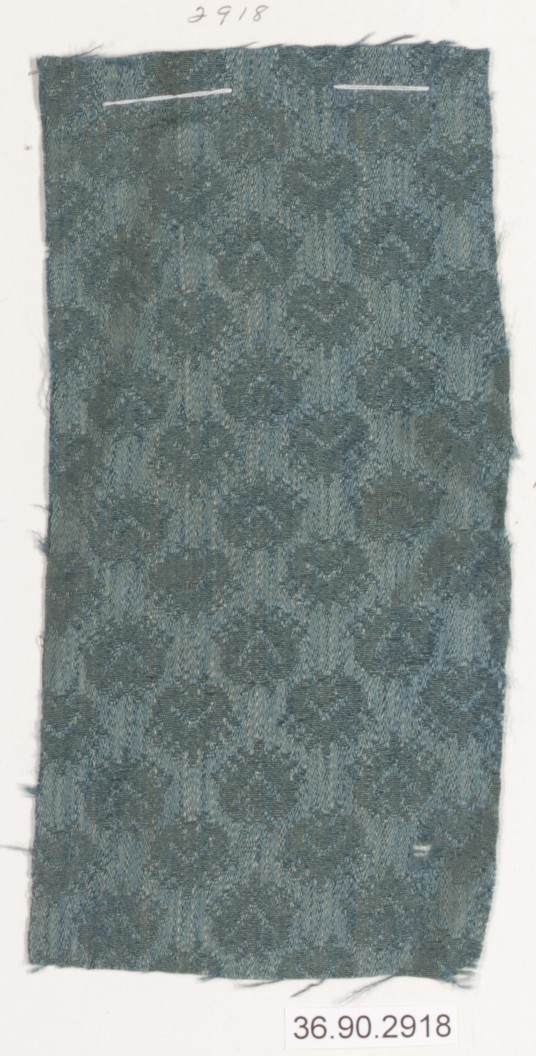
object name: piece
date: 1801-1900